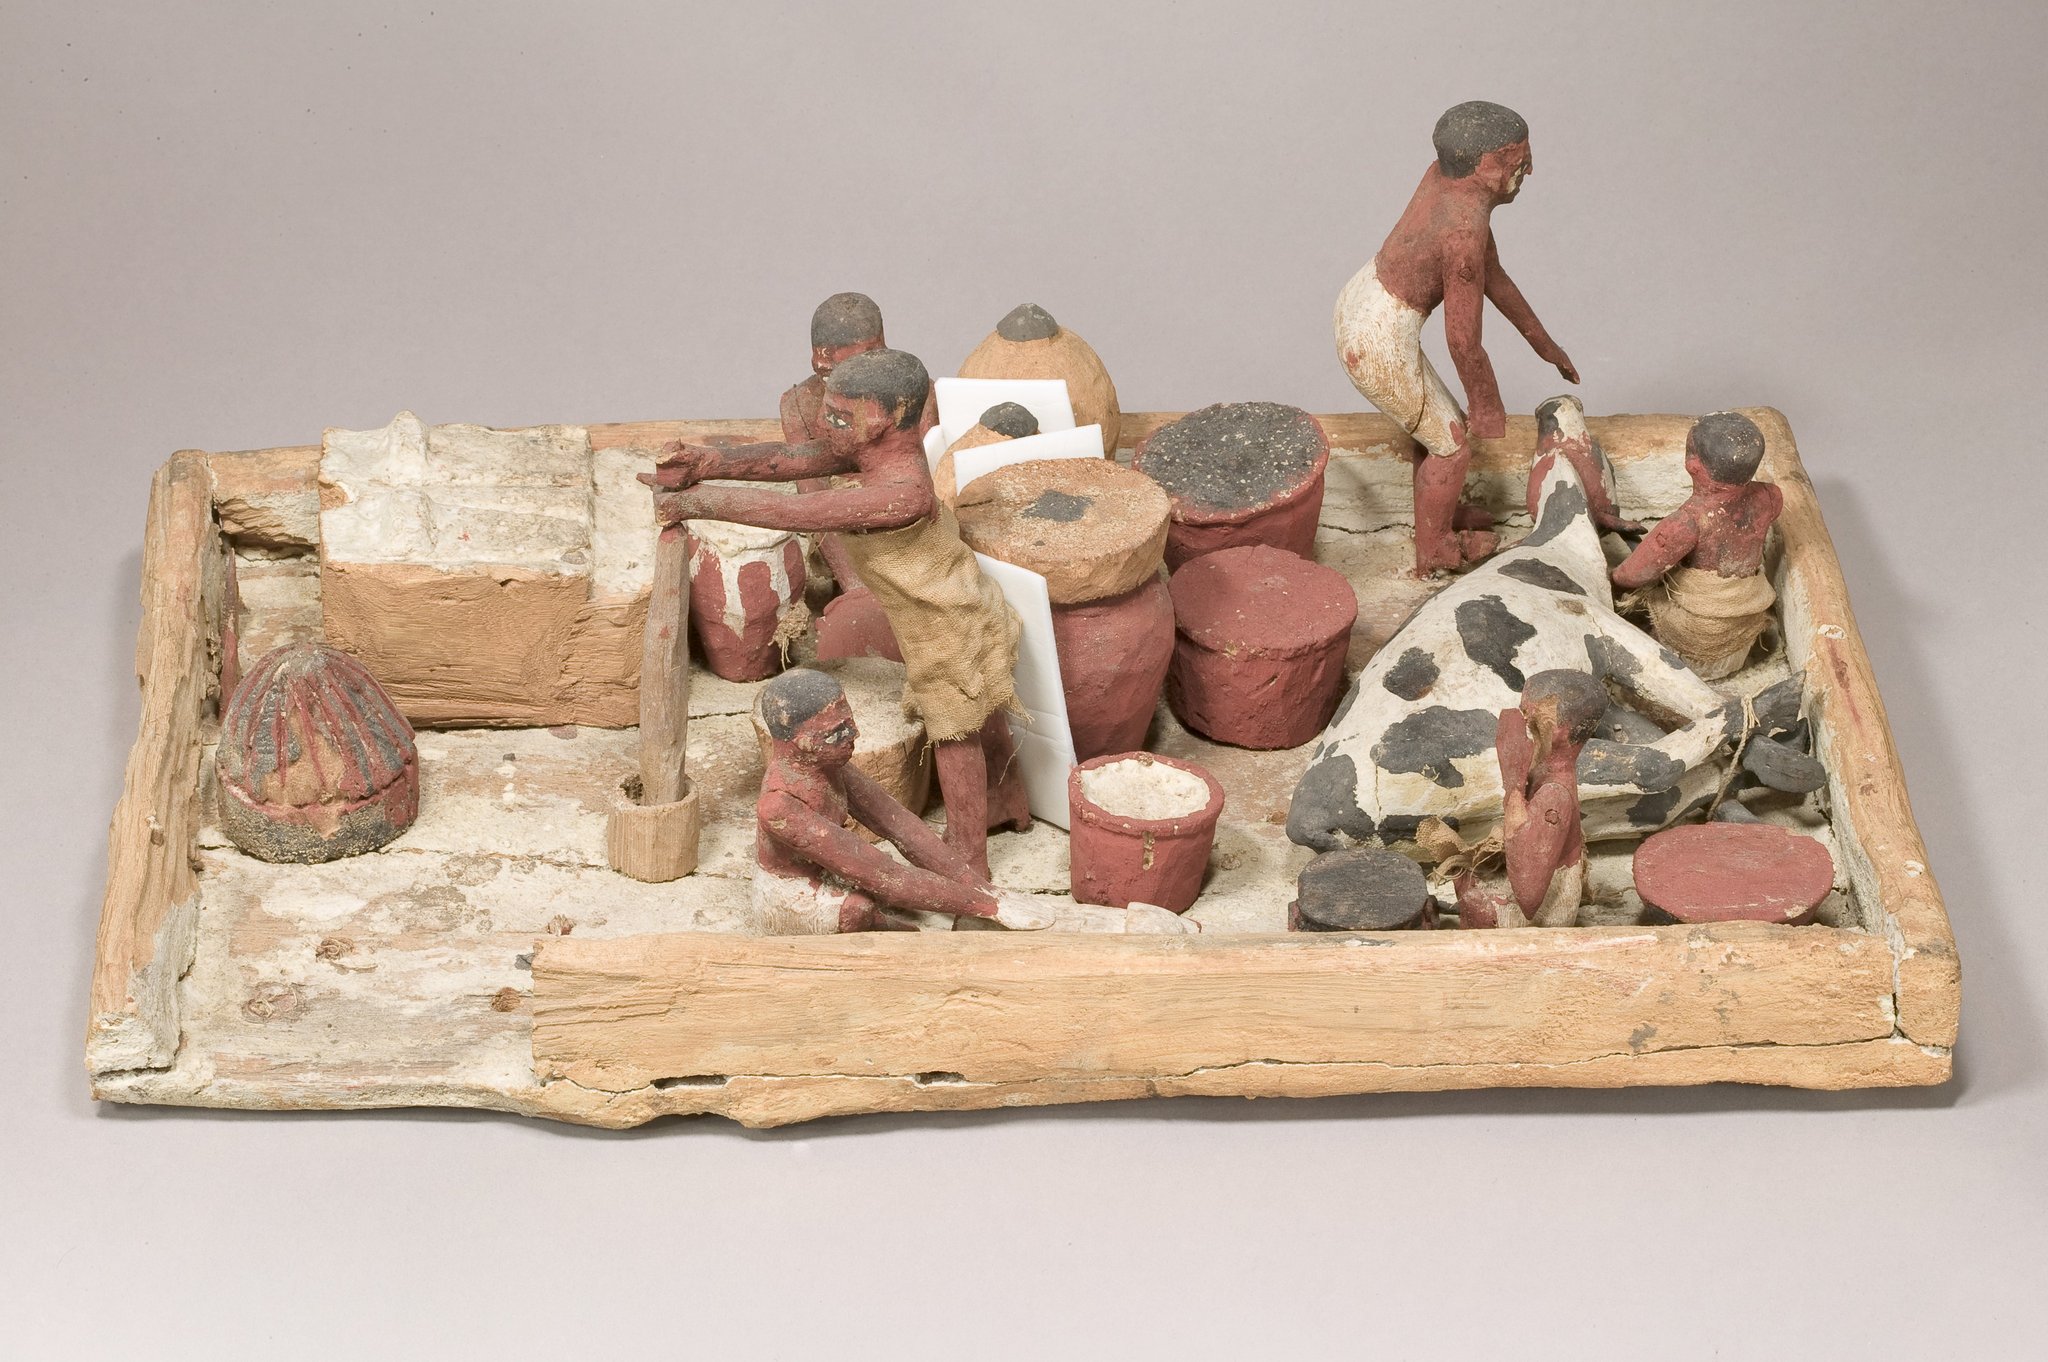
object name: model, butcher, baker, brewer, cattle, cow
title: Model of Brewers, Bakers, and Butchers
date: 2030-1640 BCE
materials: gesso, paint, wood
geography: egypt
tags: men,working,bakers,butchers